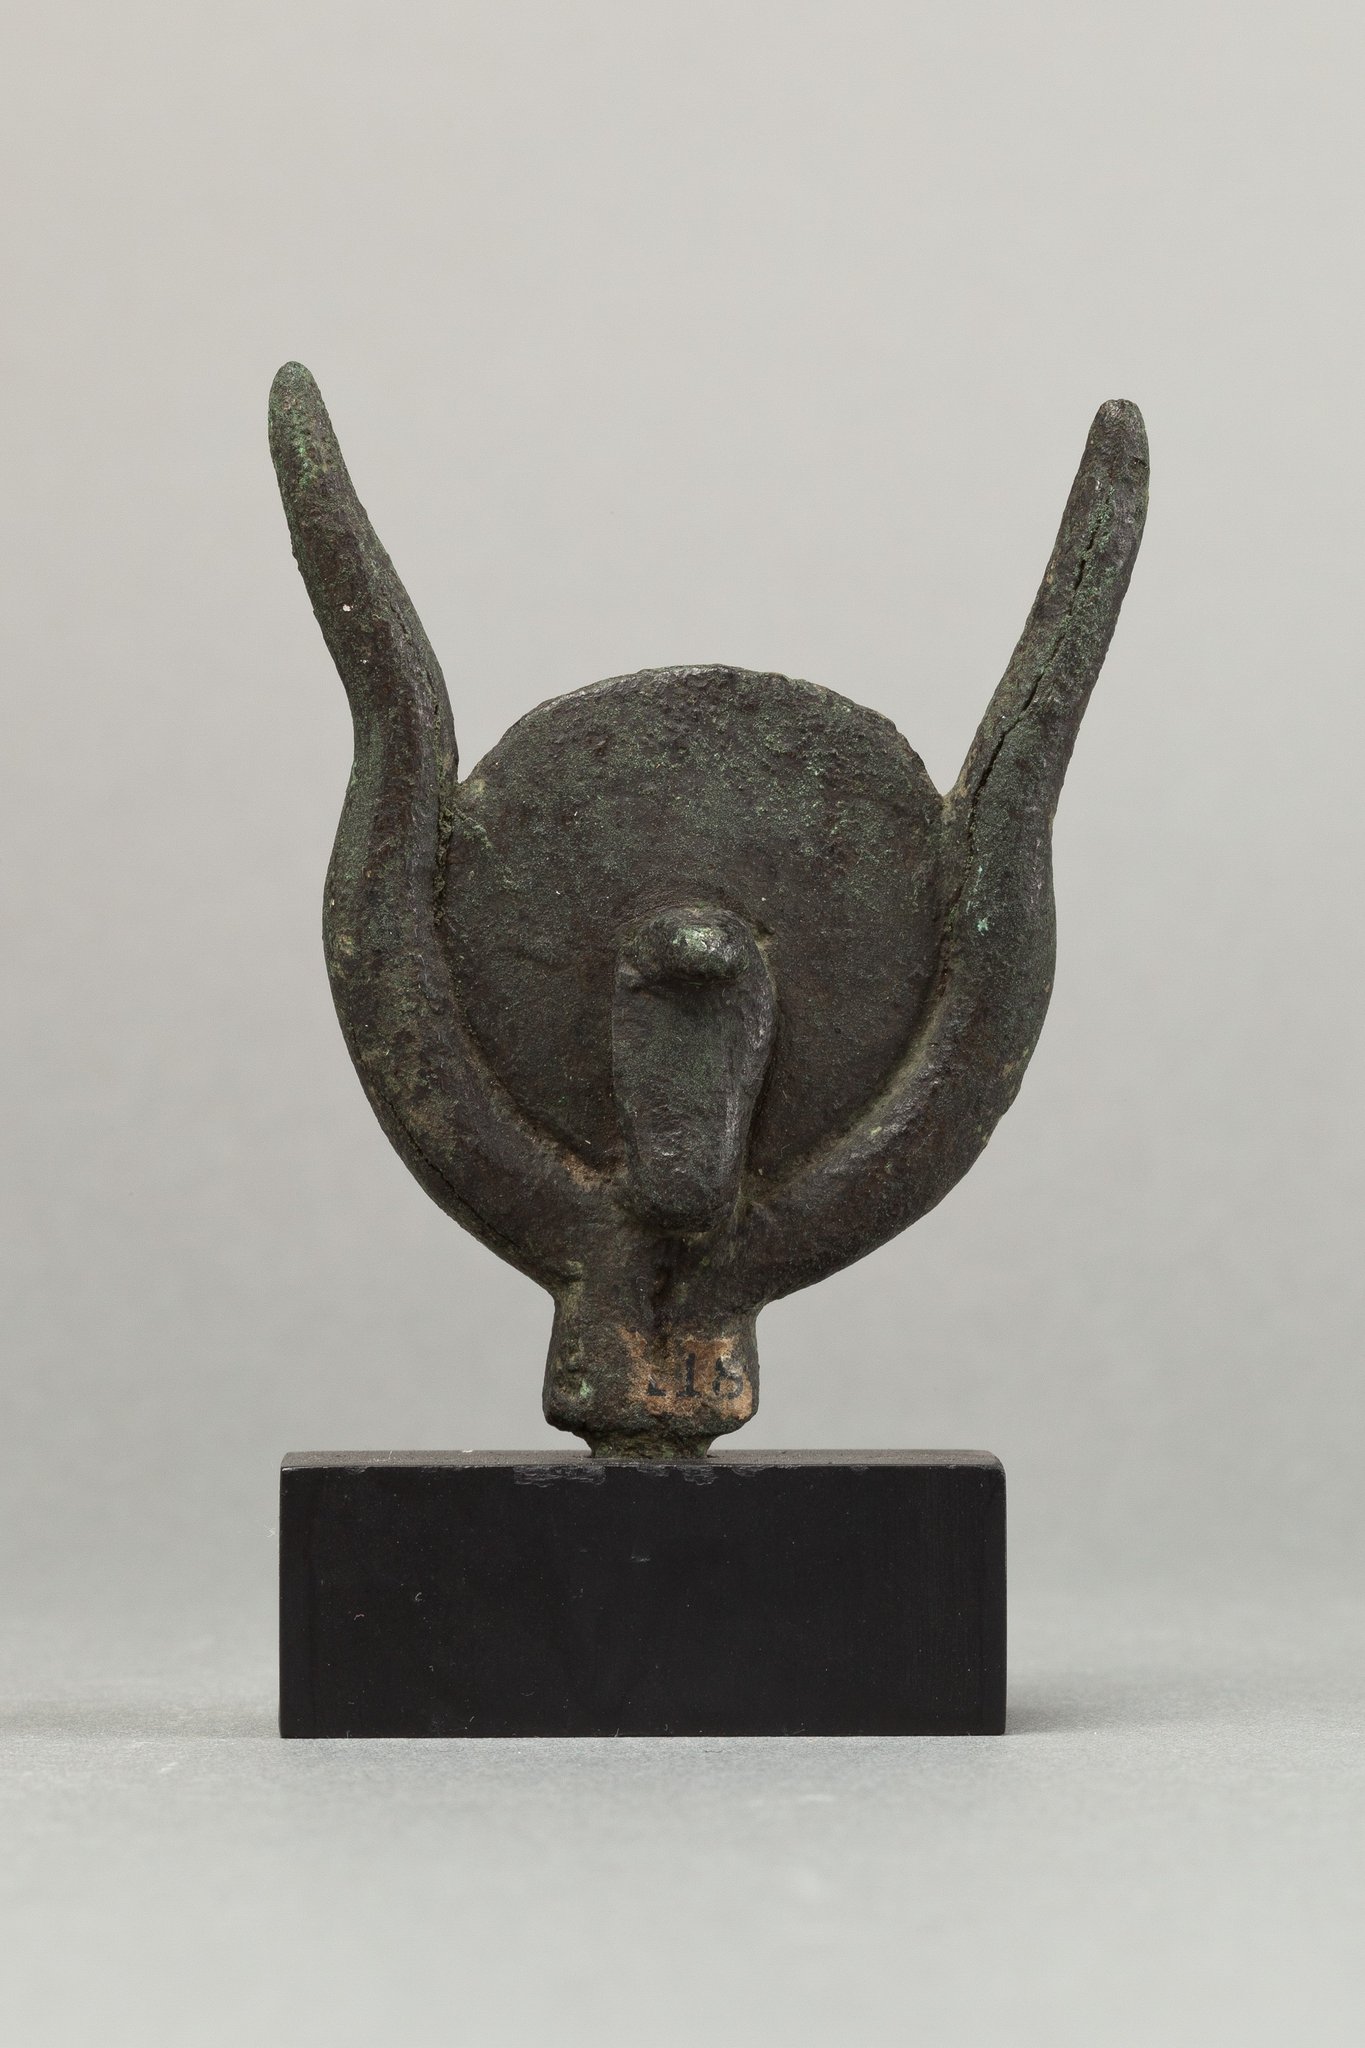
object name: headdress attachment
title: Disk and horns headdress for a goddess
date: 664-630 BCE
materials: metal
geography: egypt